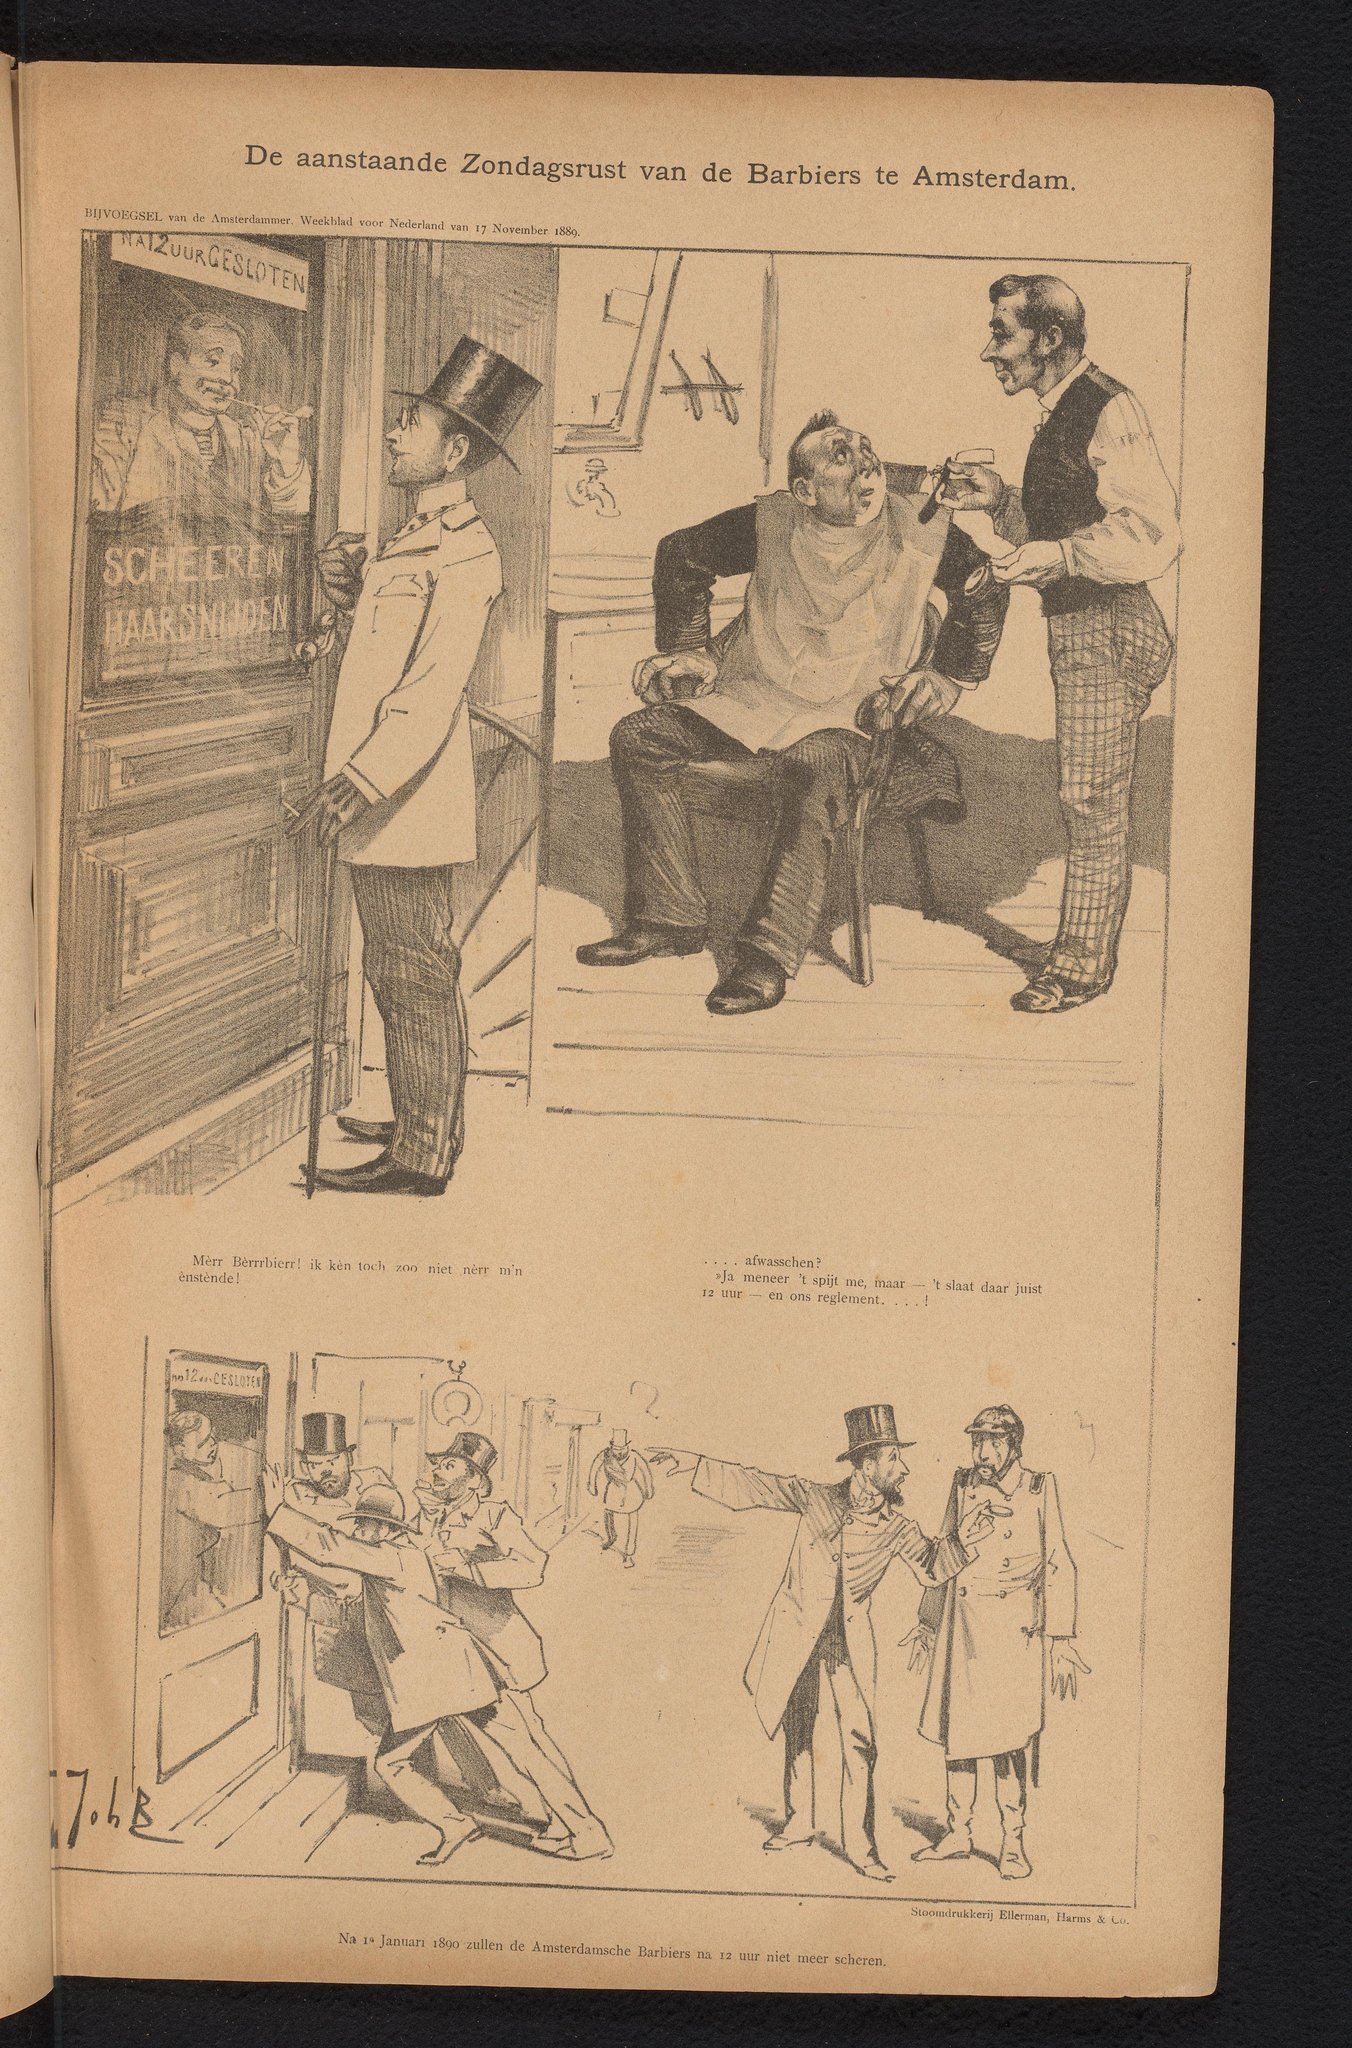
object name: cartoon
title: De aanstaande Zondagsrust van de Barbiers te Amsterdam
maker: johan braakensiek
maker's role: draughtsman, print maker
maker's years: 1858-1940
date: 1889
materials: paper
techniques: lithograph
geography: netherlands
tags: shaving, being shaved, barber, barbershop, political caricatures and satires, amsterdam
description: Verschillende humoristische scènes die het gevolg zijn van de nieuwe wet dat barbiers in Amsterdam niet meer na 12 uur hun klanten mogen scheren.